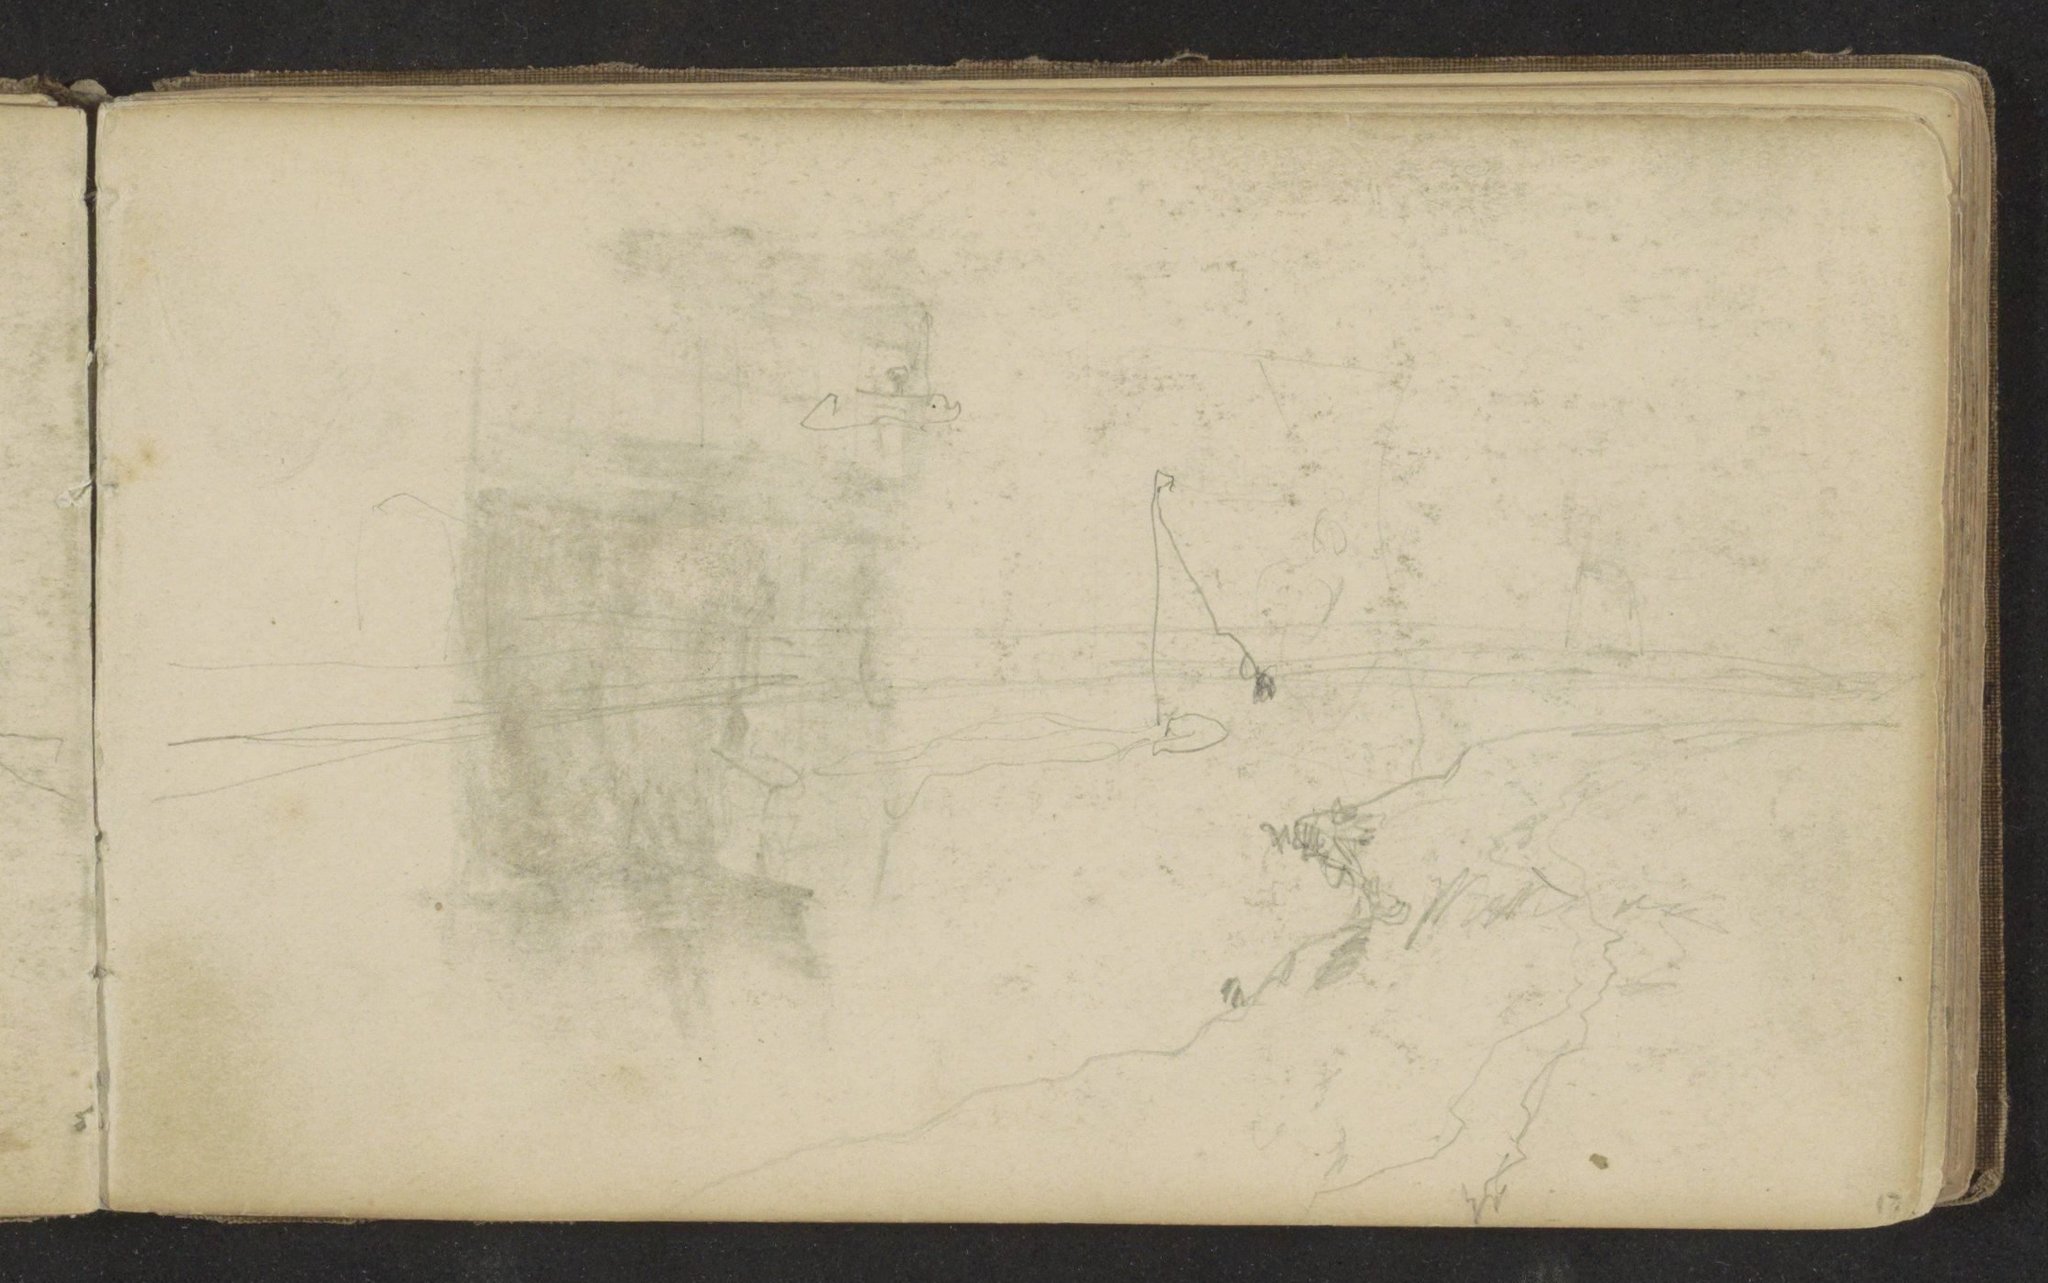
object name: sketchbook leaf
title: Zeilboot op een vaart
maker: johan hendrik weissenbruch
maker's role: draughtsman, painter, print maker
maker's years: 1824-1903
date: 1834-1903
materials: paper, pencil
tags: sailing-ship, sailing-boat, canal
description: Blad 17 recto uit een schetsboek met 43 bladen.